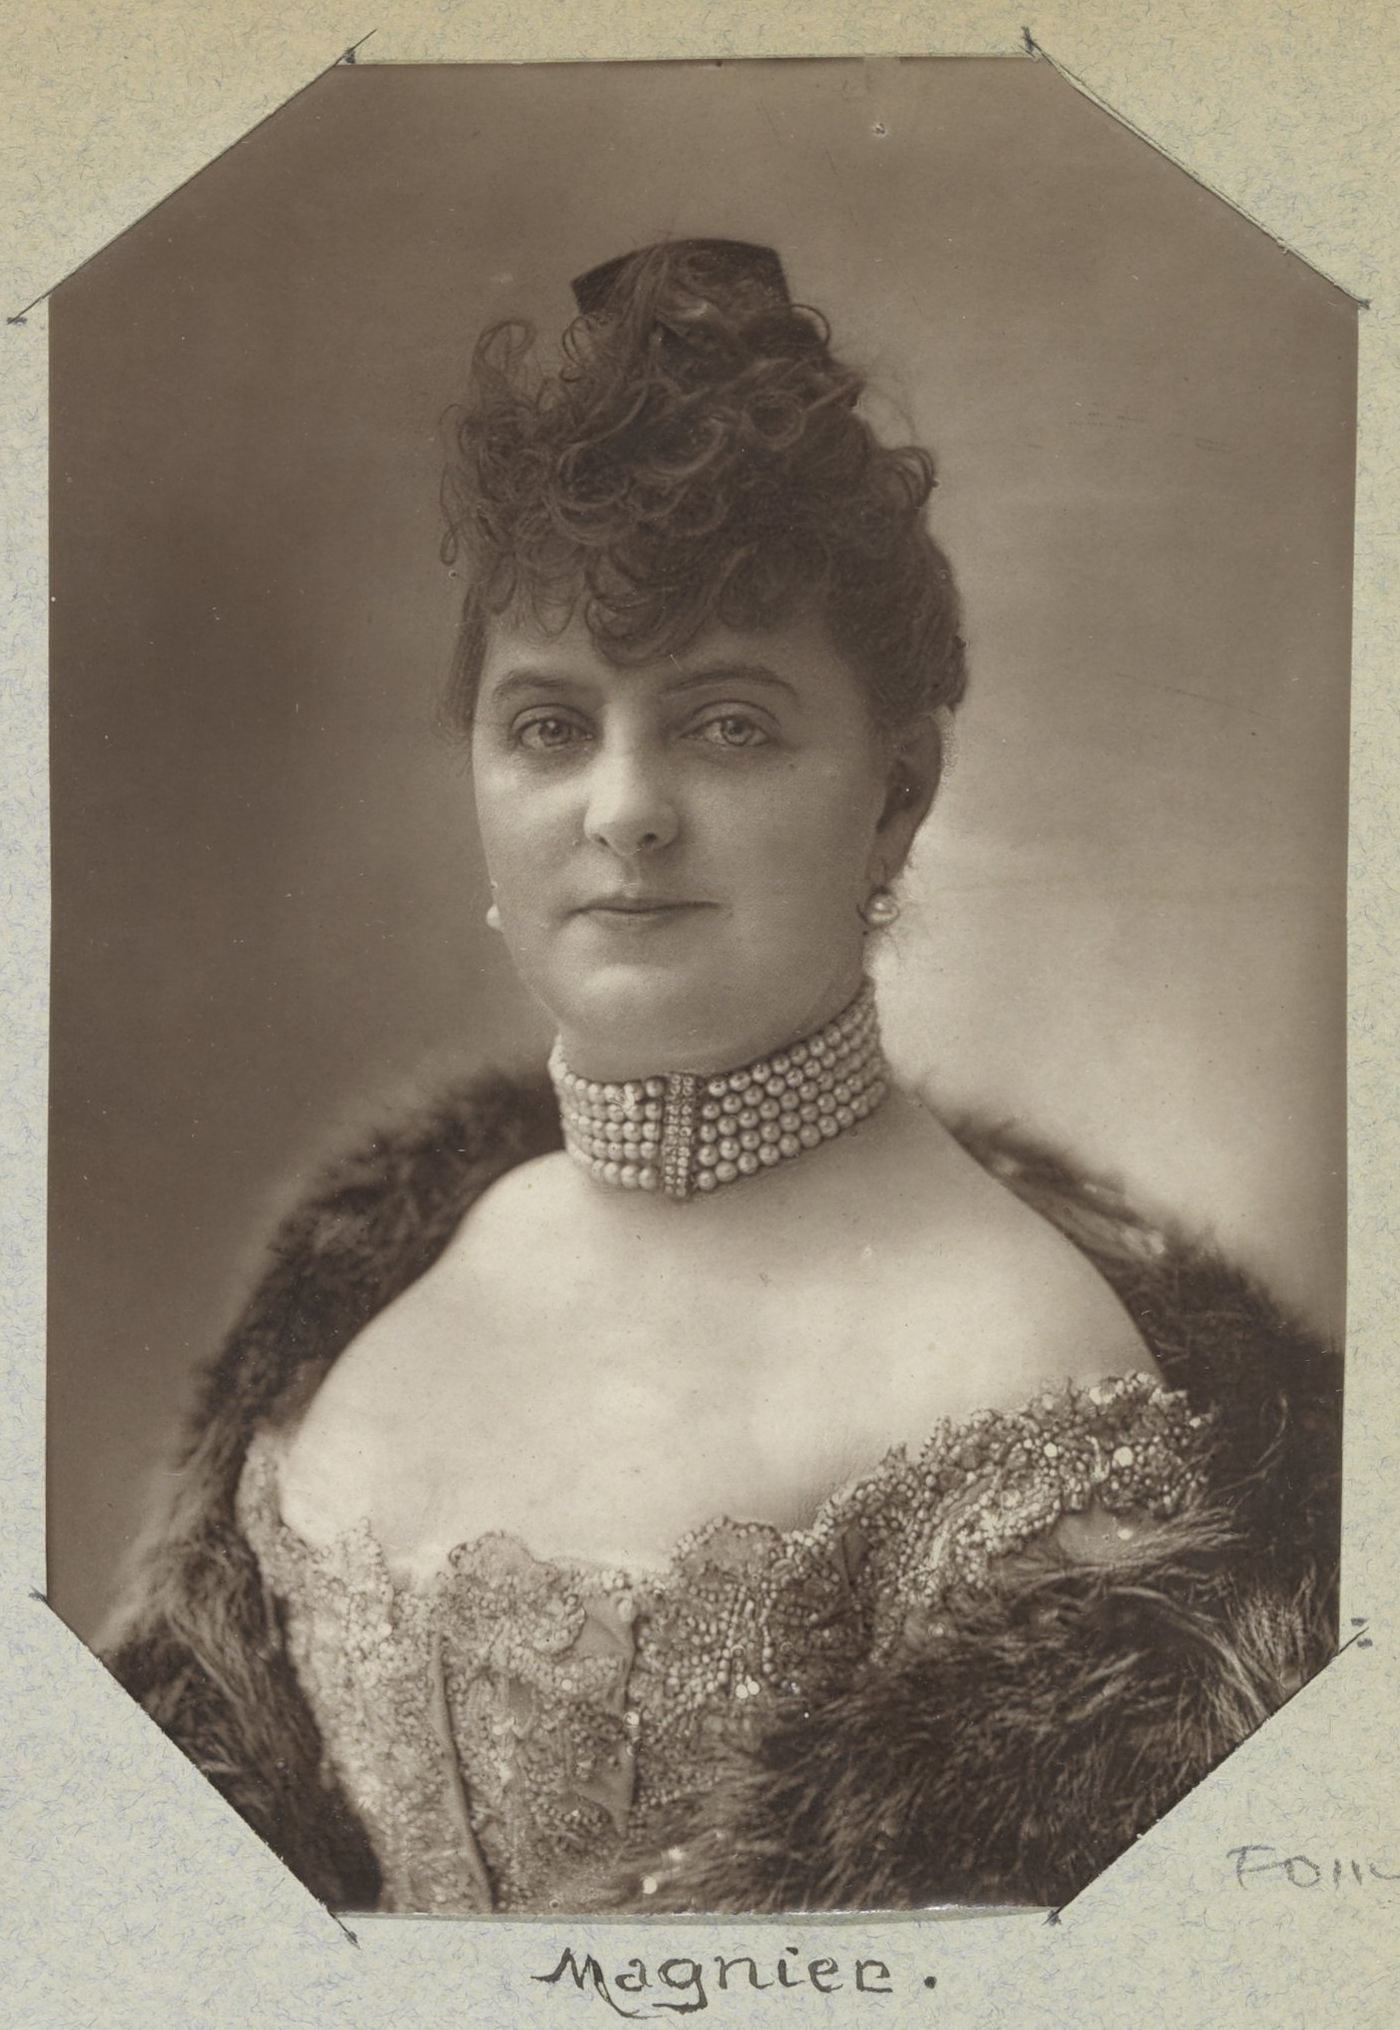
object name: photograph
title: Portret van Marie Magnier, actrice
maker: Anonymous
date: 1890-1900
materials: paper, photographic support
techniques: carbon print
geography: france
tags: portrait of actor, actress, france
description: Onderdeel van Album van een Franse amateur met foto's van Frankrijk, Algerije, Palmyra, de Wereldtentoonstelling van 1900 en van bekende Fransen.